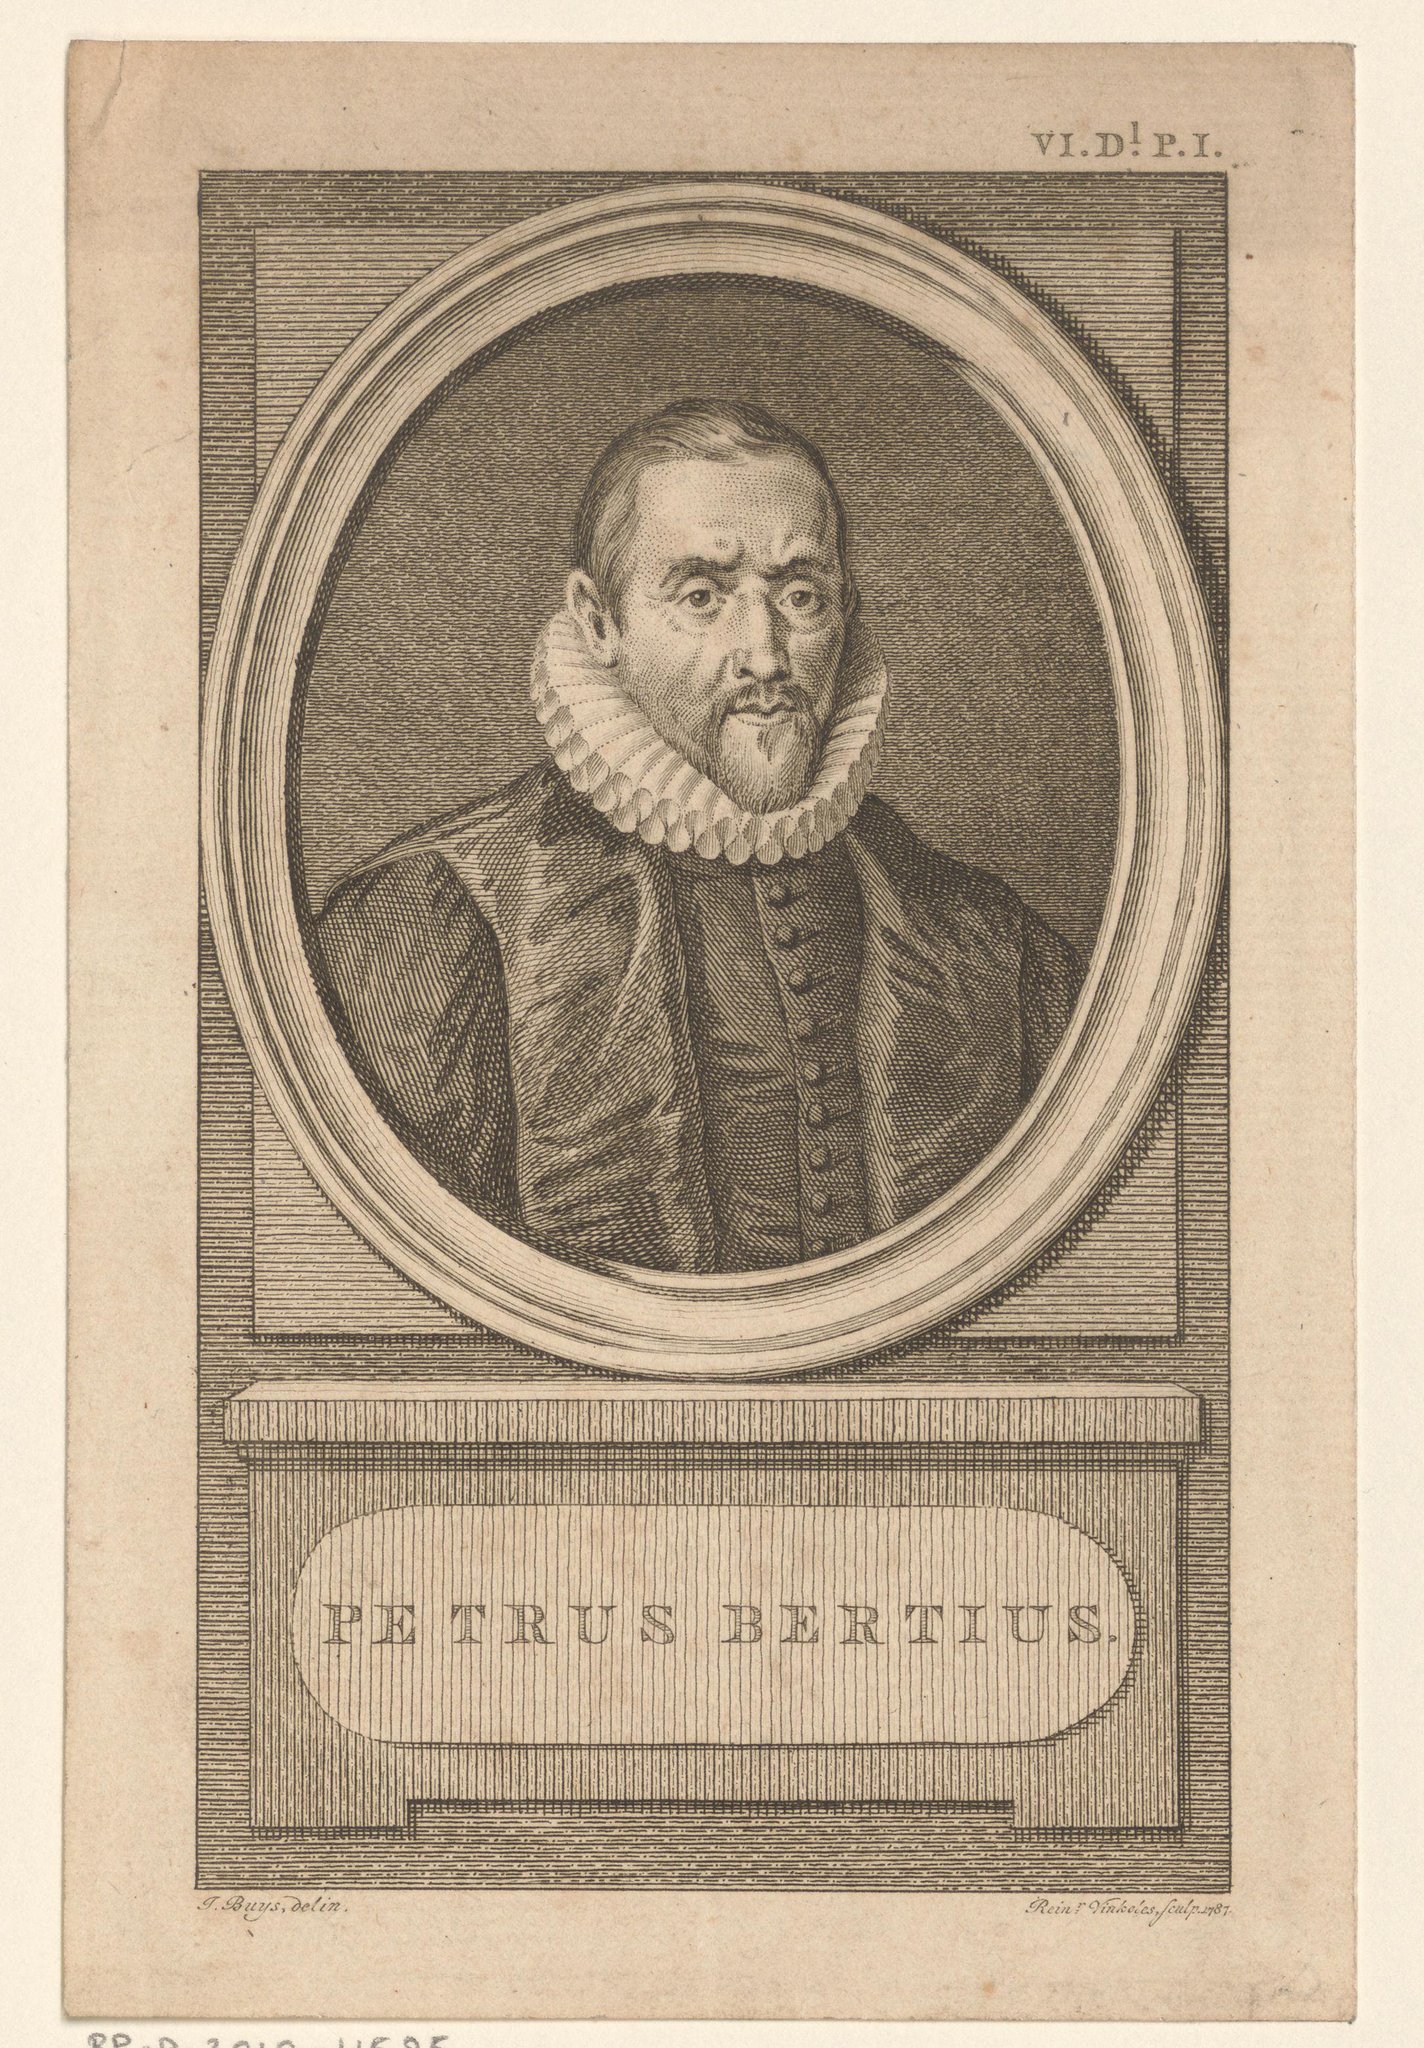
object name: print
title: Portret van Petrus Bertius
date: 1787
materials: paper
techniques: engraving, etching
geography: amsterdam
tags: paris, historical persons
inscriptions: collector's mark: Lugt 2228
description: Prent uit: Kok, Jacobus. Vaderlandsch woordenboek: met kaarten, plaaten en pourtraitten. Amsterdam: Johannes Allart, 1785-1796, dl. 6.